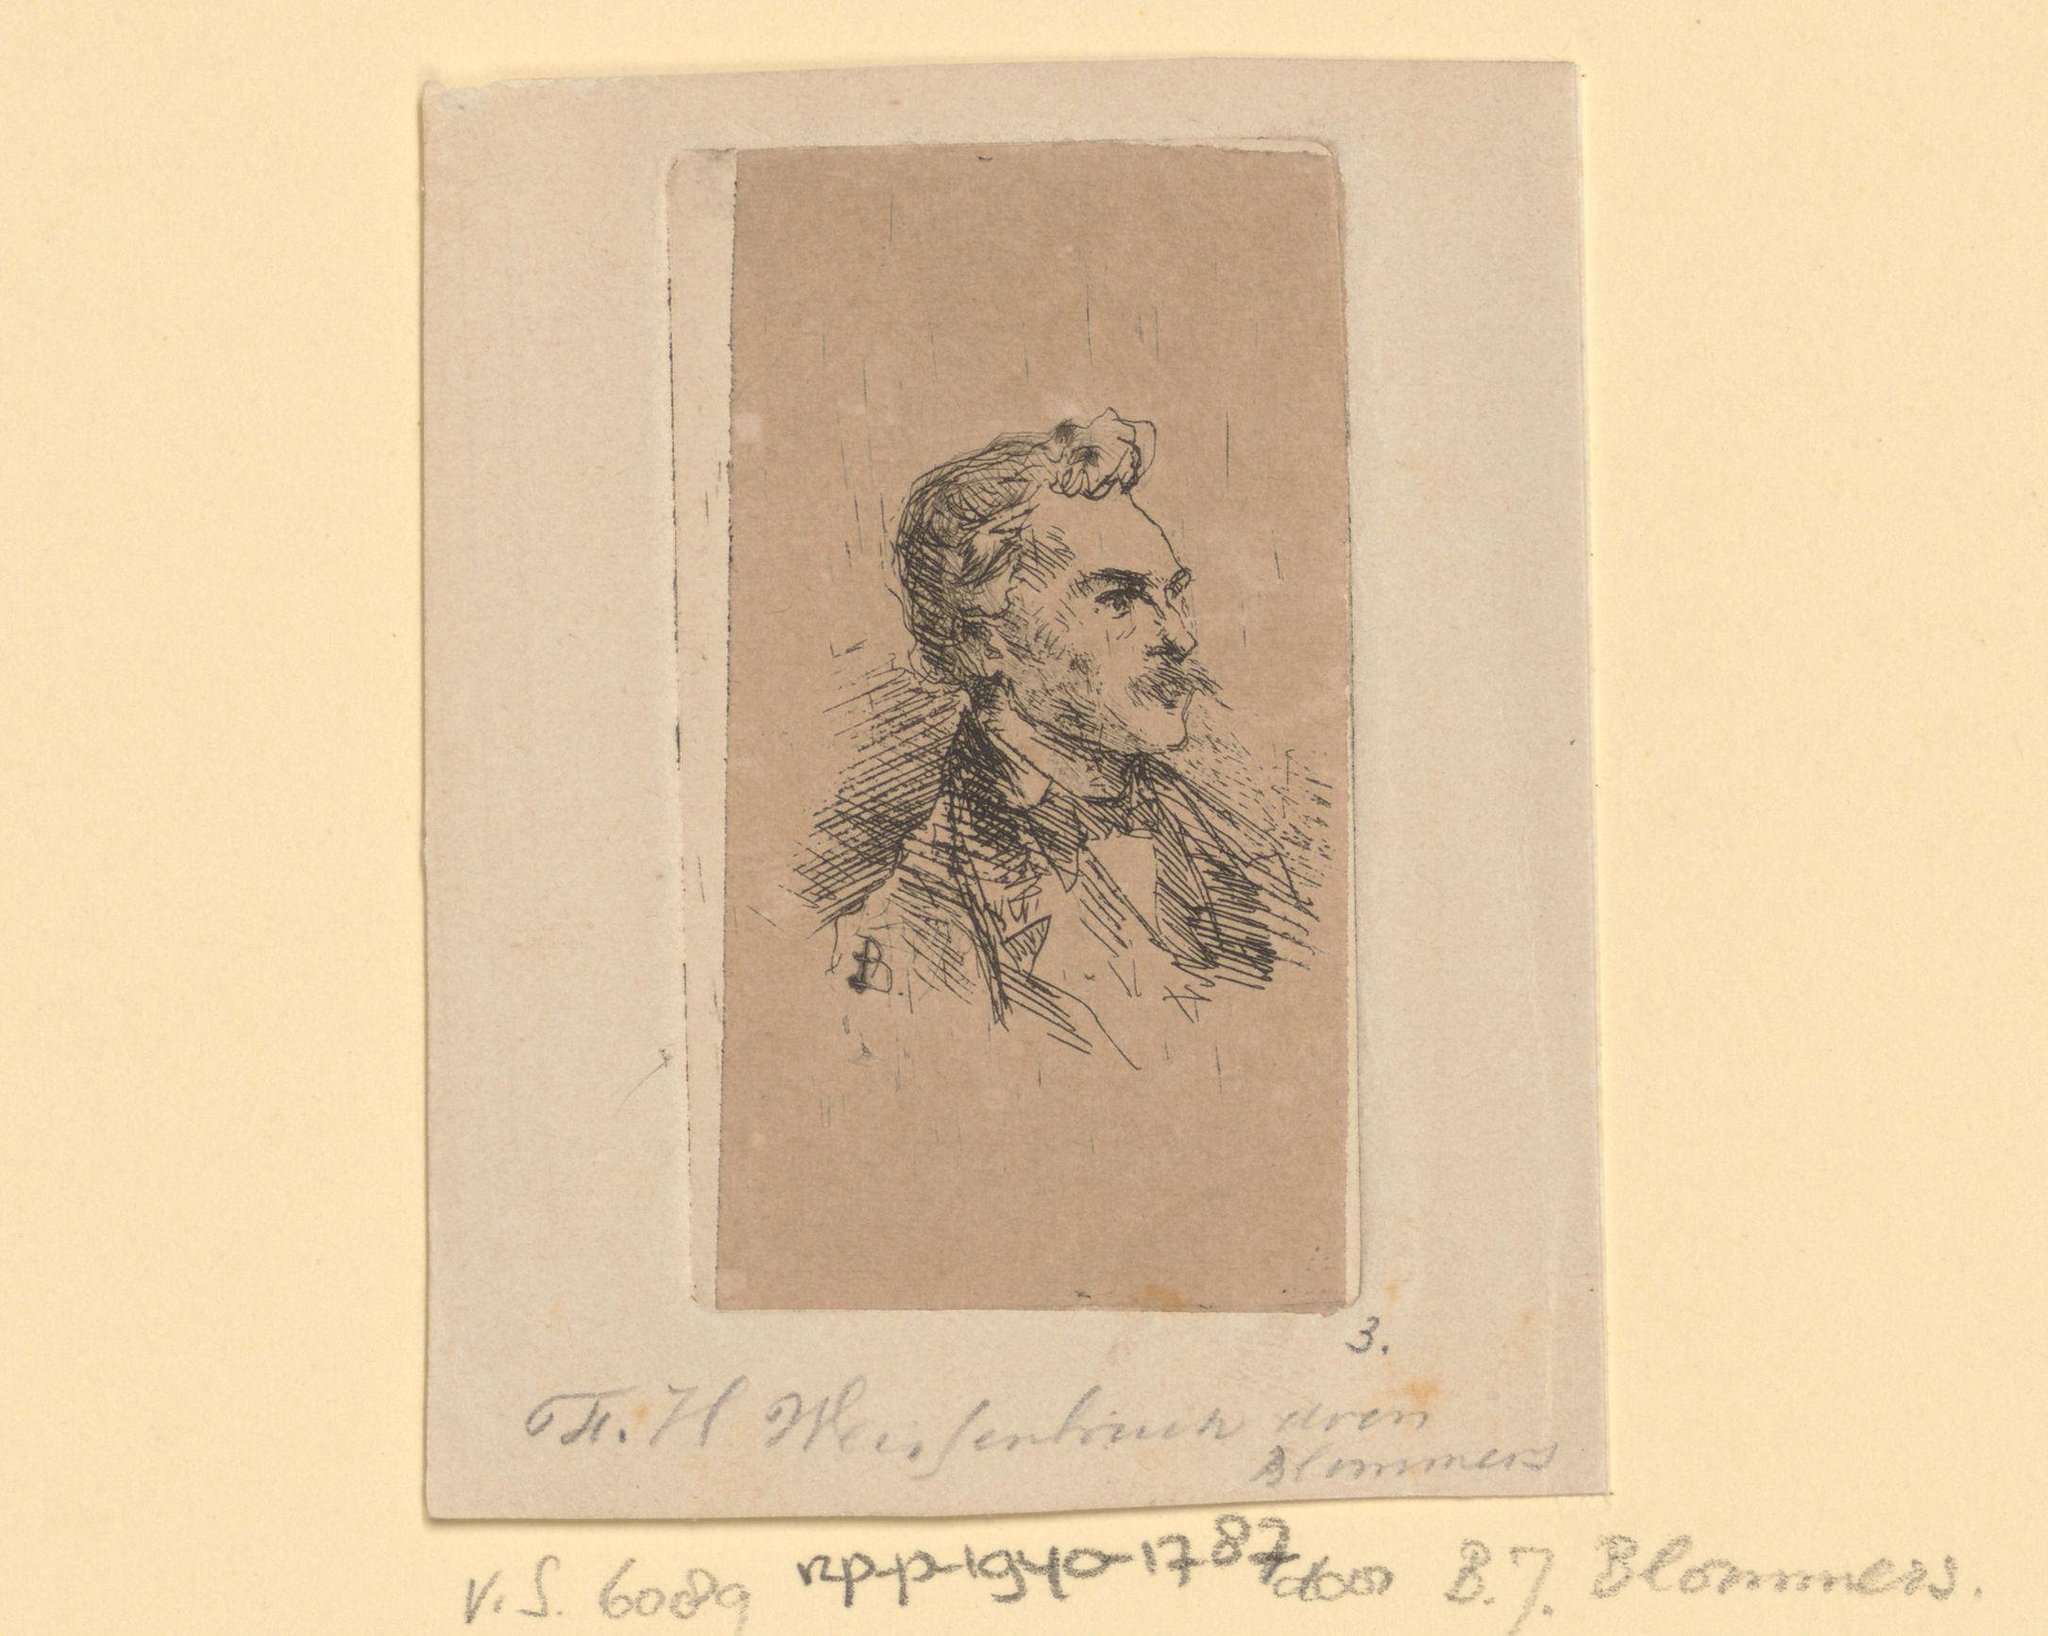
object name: print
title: Portret van Frederik Hendrik Weissenbruch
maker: bernardus johannes blommers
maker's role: draughtsman, print maker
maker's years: 1845-1914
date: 1855-1891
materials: paper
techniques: etching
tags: the hague, print maker, draughtsman, frederik hendrik weissenbruch, historical persons, portrait, self-portrait of graphic artist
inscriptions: collector's mark: Lugt 2760, number: ‘3.’, collector's mark: Lugt 2228